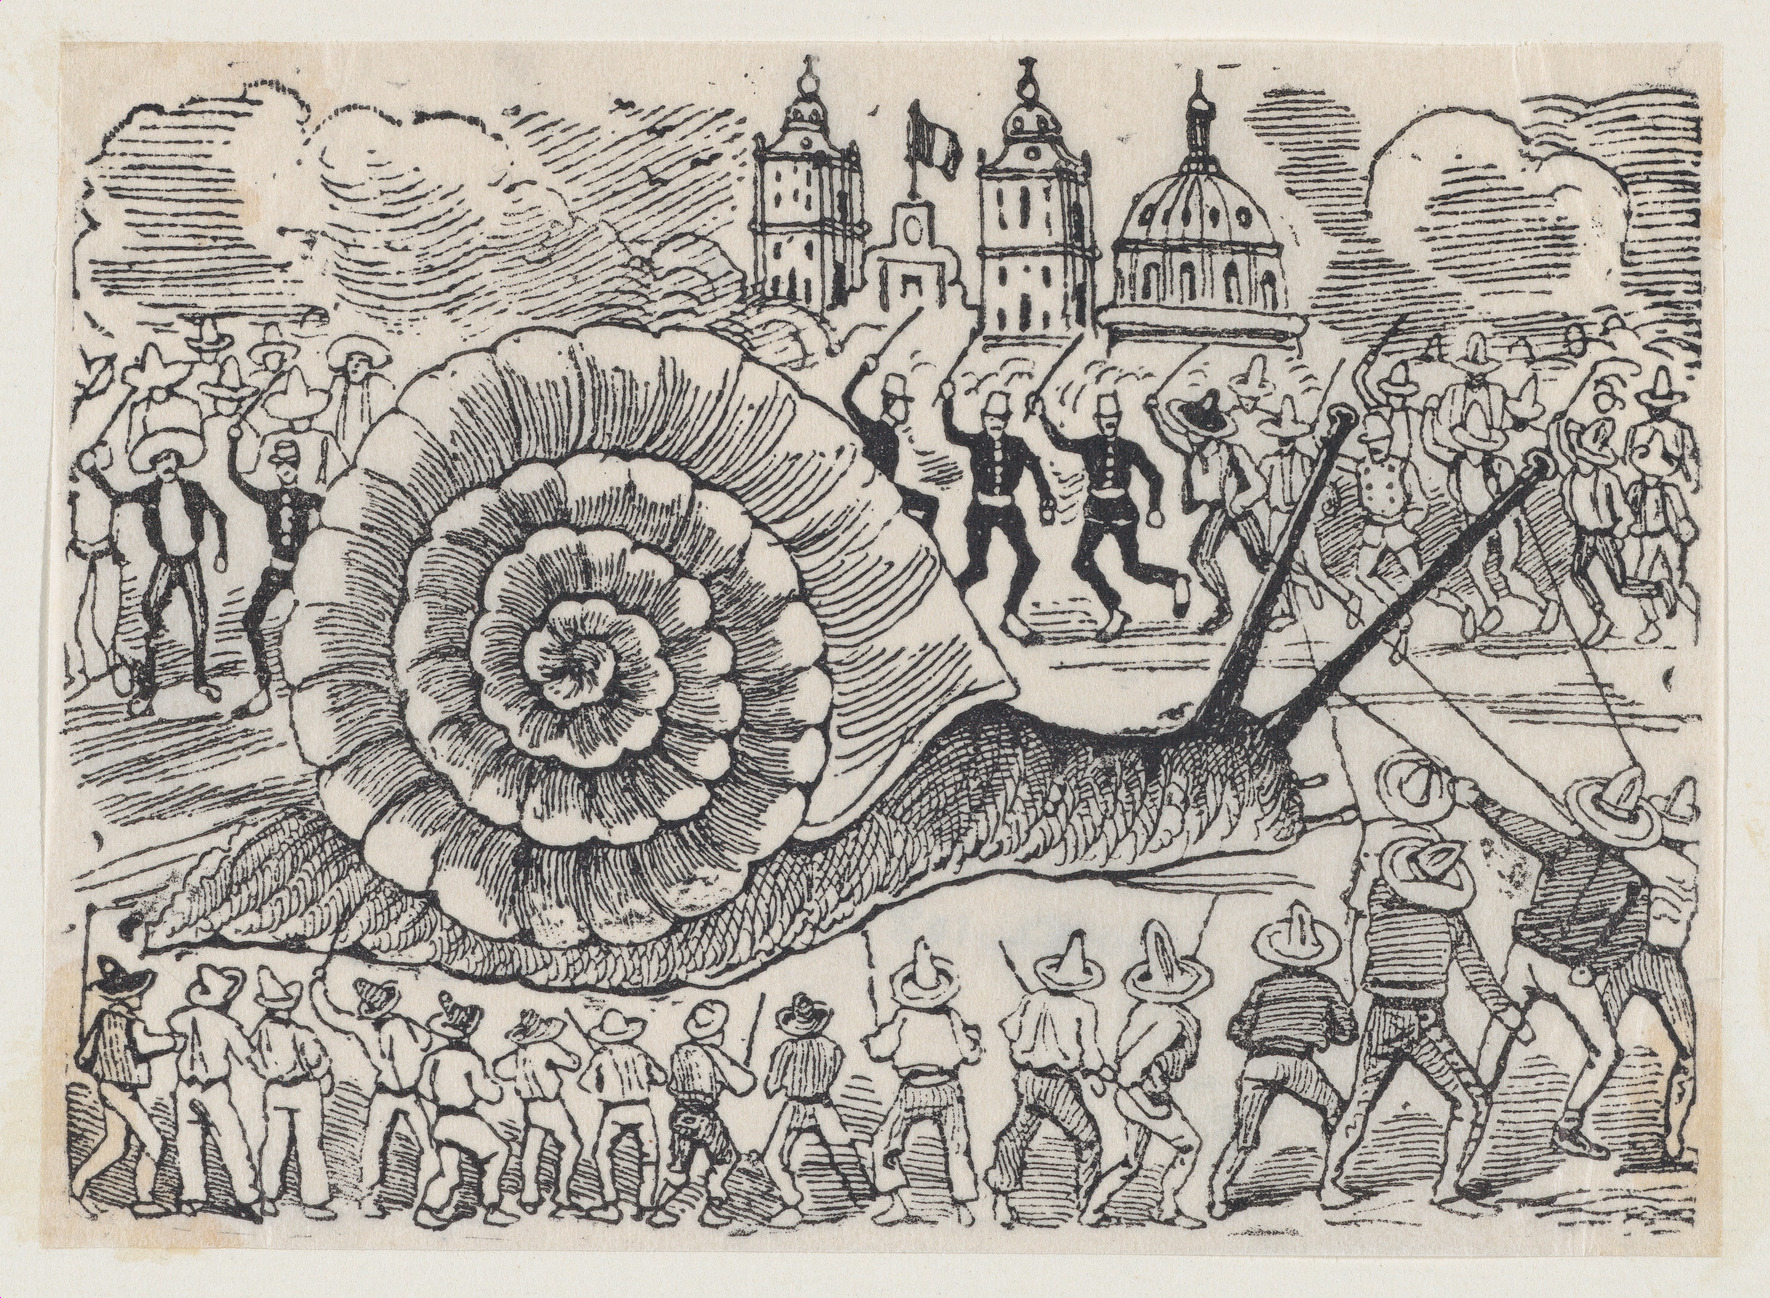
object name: print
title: Ballad of the Snail (Corrido del Caracol)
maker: josé guadalupe posada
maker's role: artist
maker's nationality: mexican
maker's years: 1852-1913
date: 1899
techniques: lithography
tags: snails,crowd